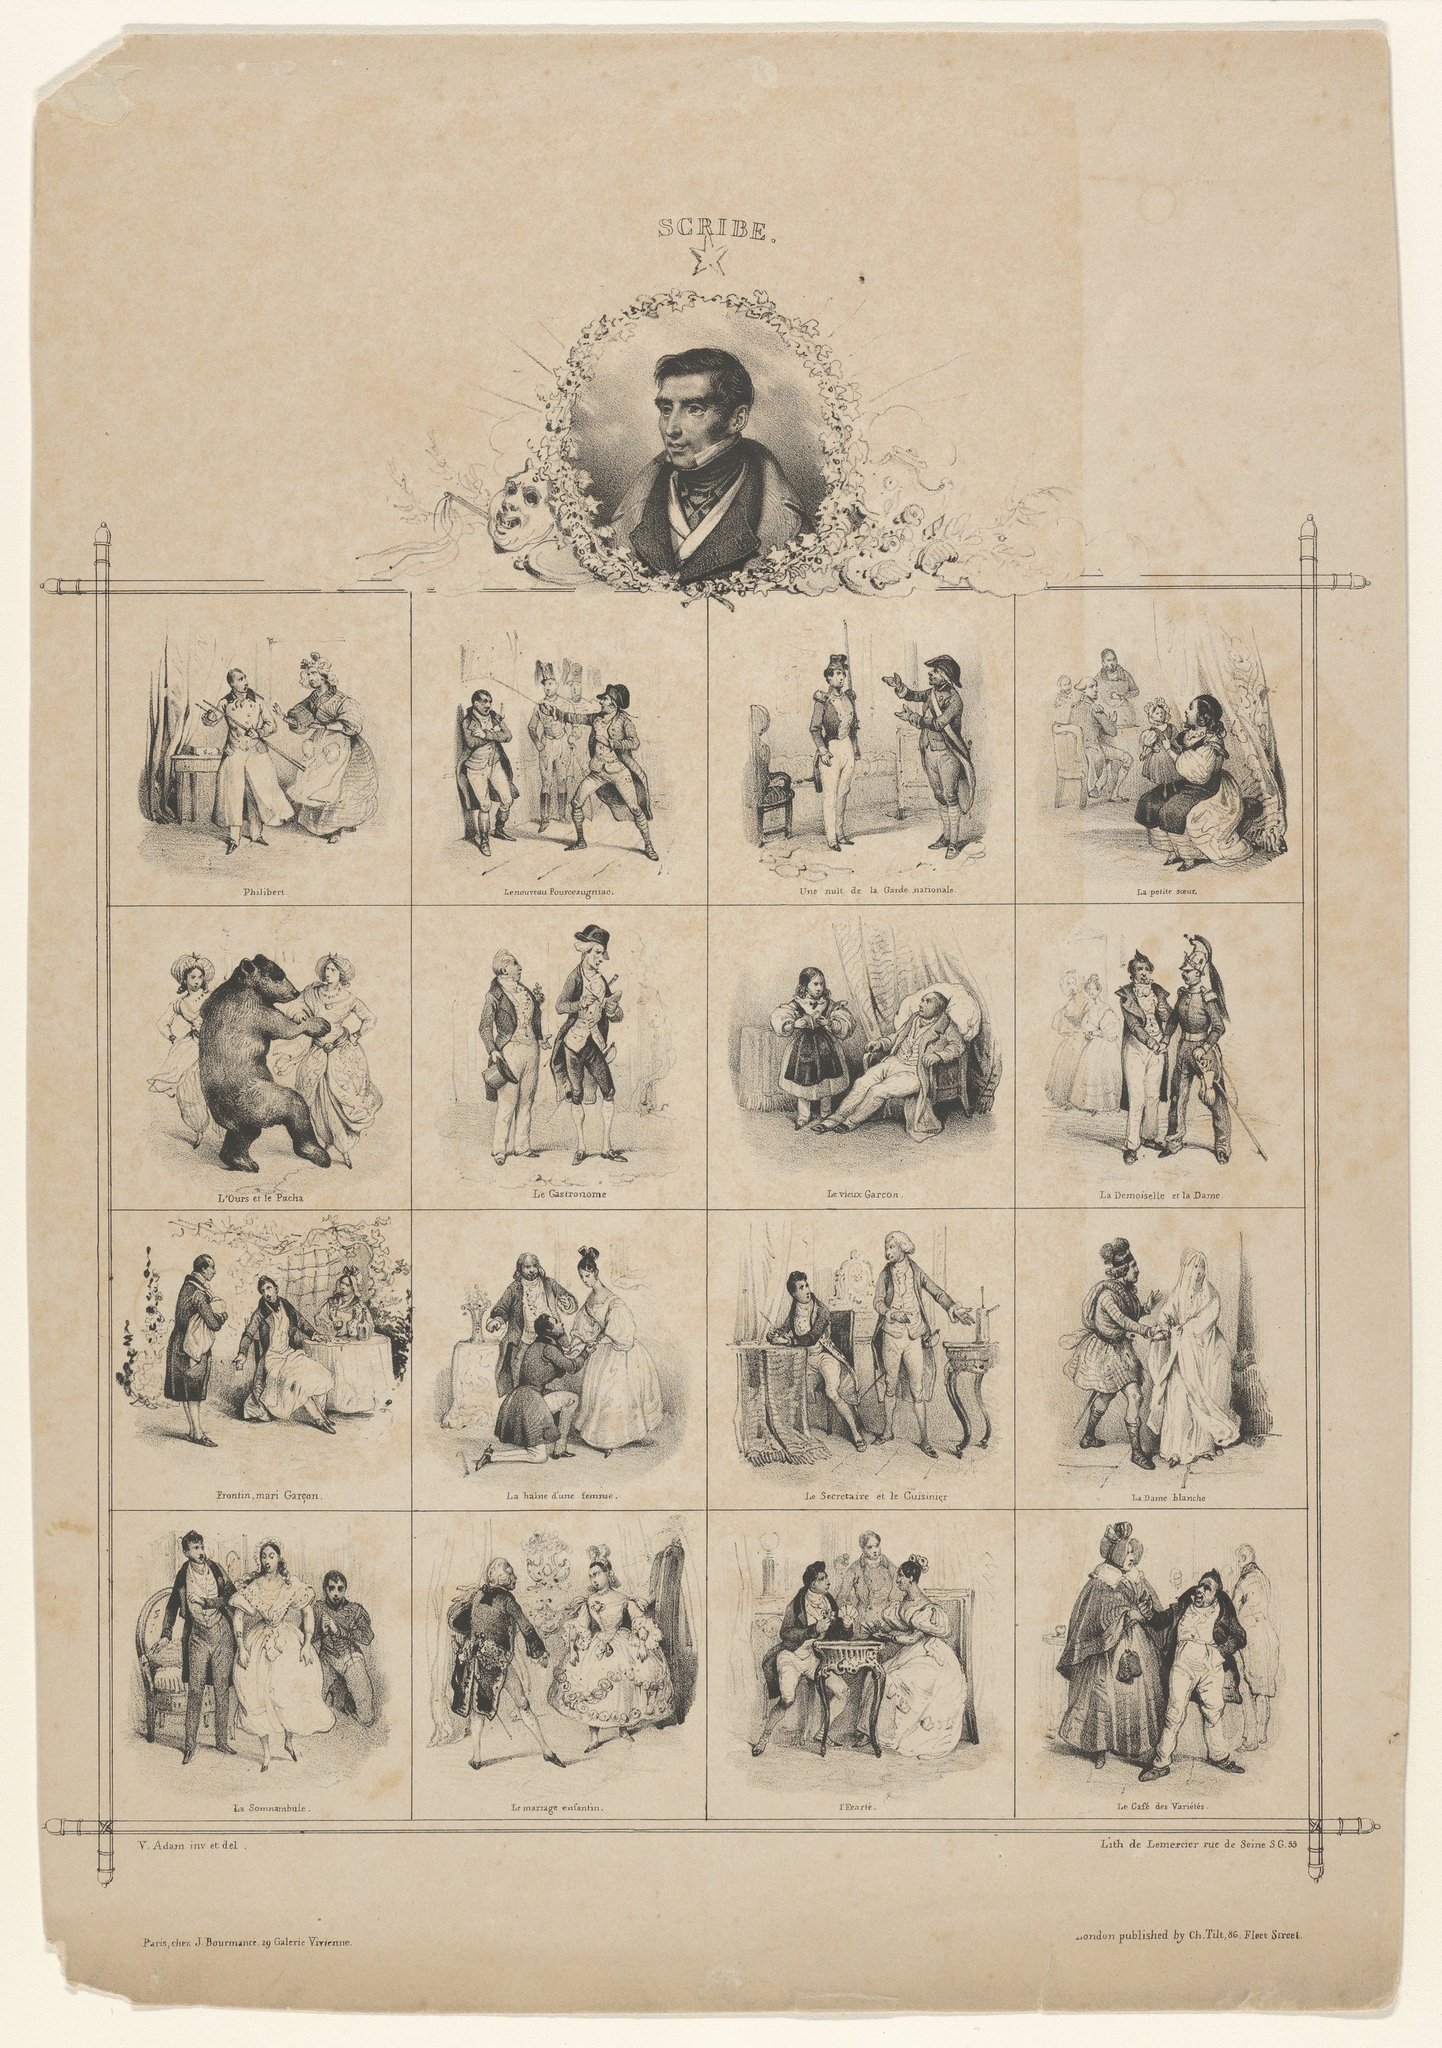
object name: print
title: Augustin-Eugène Scribe with Characters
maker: victor adam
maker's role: artist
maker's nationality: french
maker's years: 1801-1866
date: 1801-1900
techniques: lithograph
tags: bears,girls,men,portraits,women